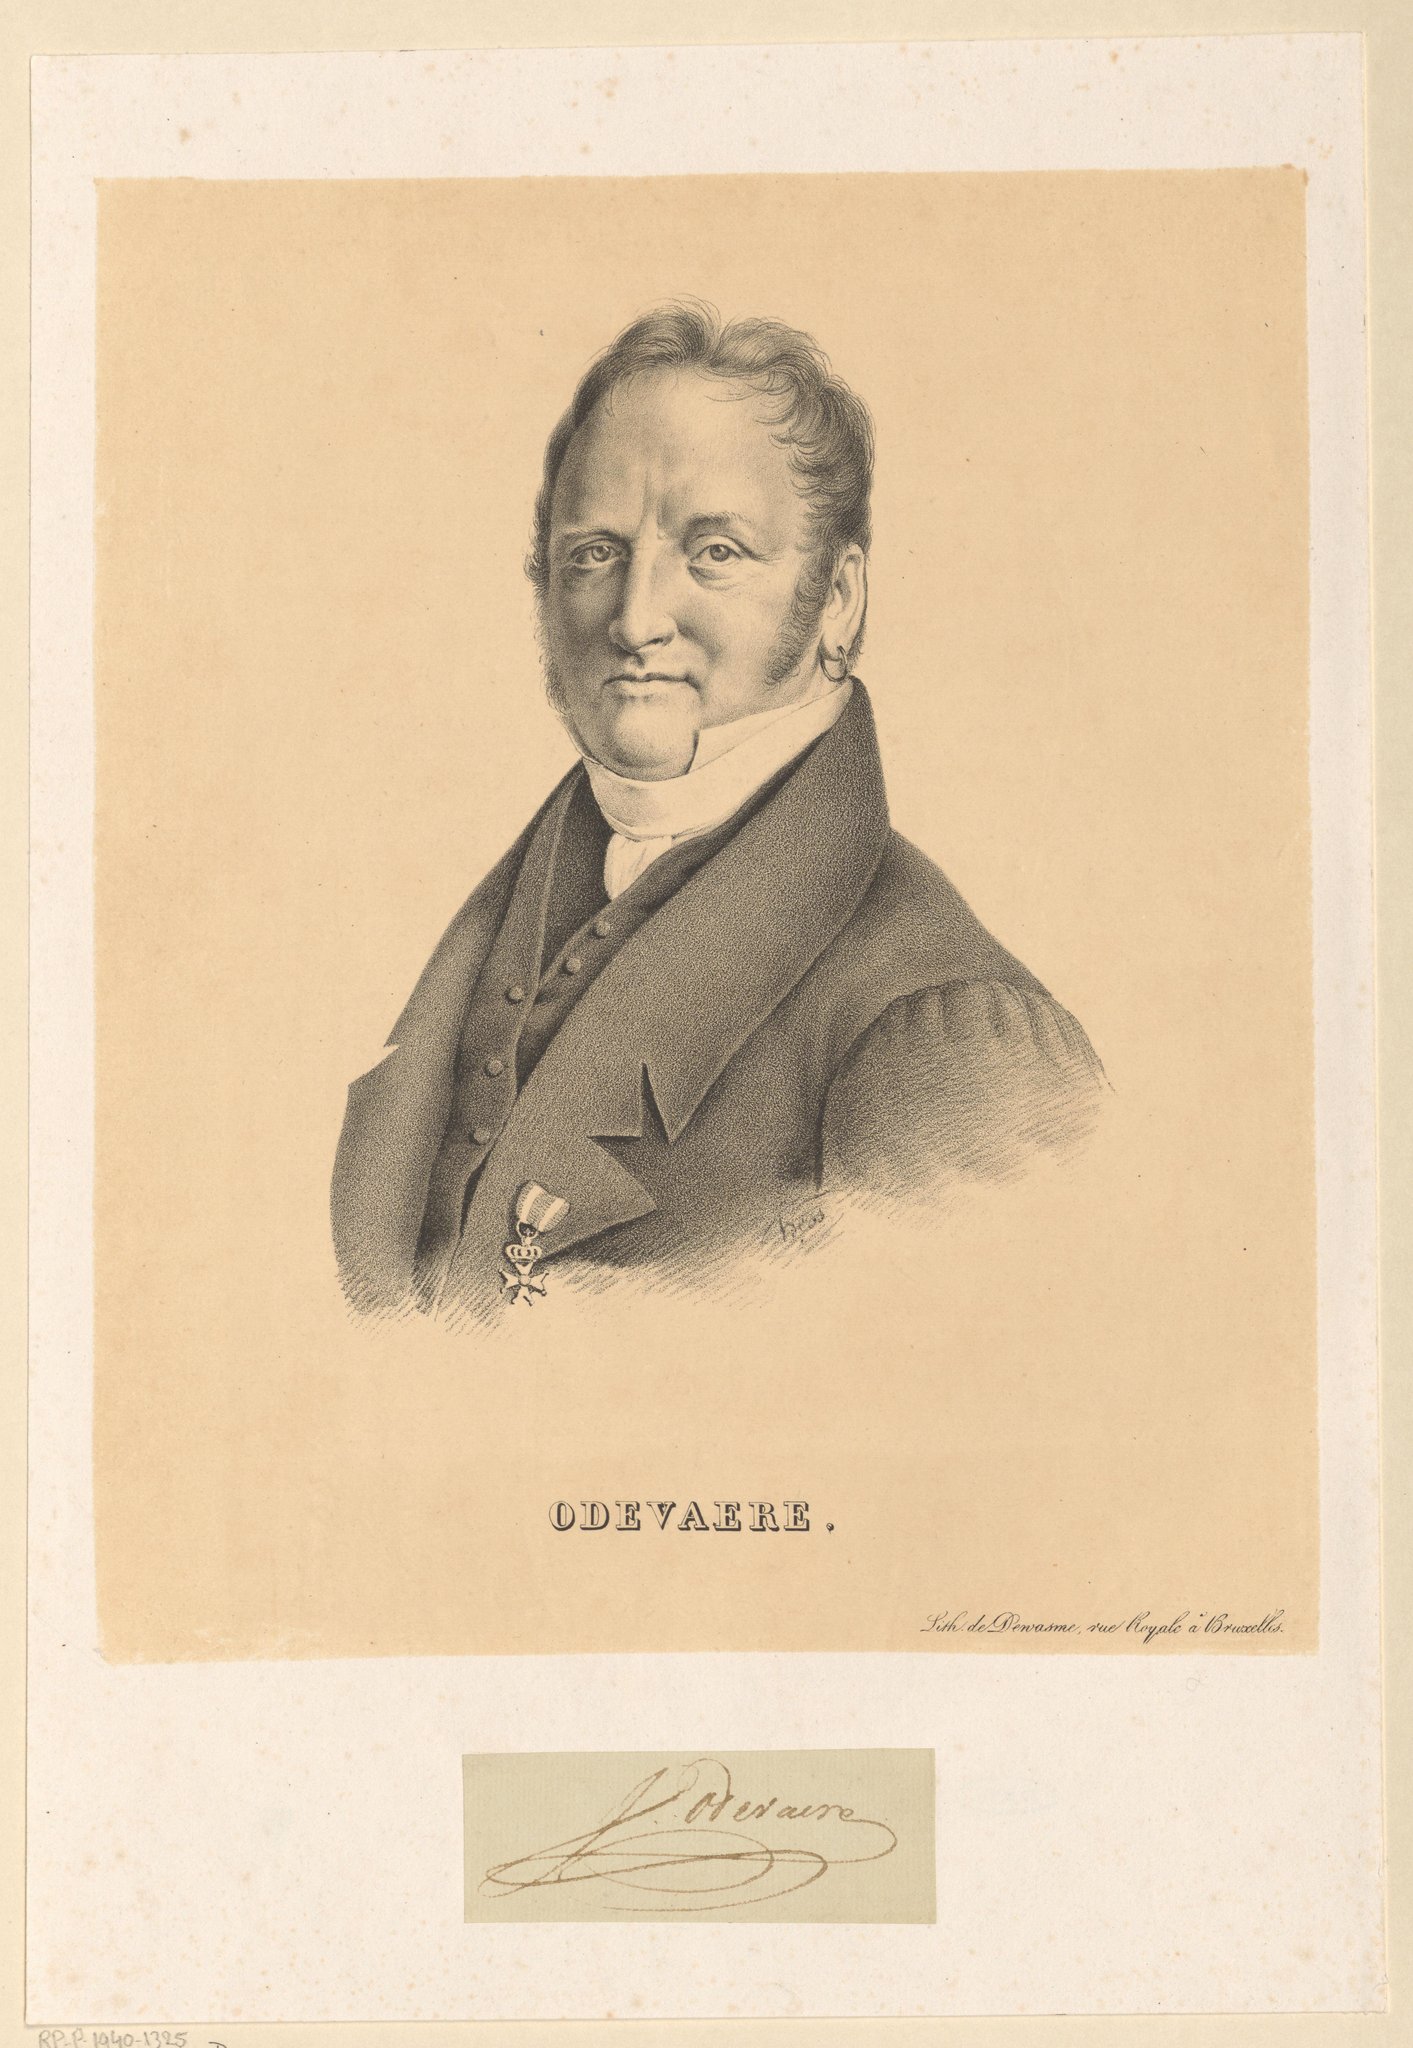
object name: print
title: Portret van Joseph-Denis Odevaere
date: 1815-1817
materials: paper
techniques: tone lithography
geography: brussels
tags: bruges, brussels, painter, print maker, joseph-denis odevaere, historical persons, portrait, self-portrait of painter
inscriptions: collector's mark: Lugt 2760, collector's mark: Lugt 2228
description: Onder het portret de handtekening van de geportretteerde.